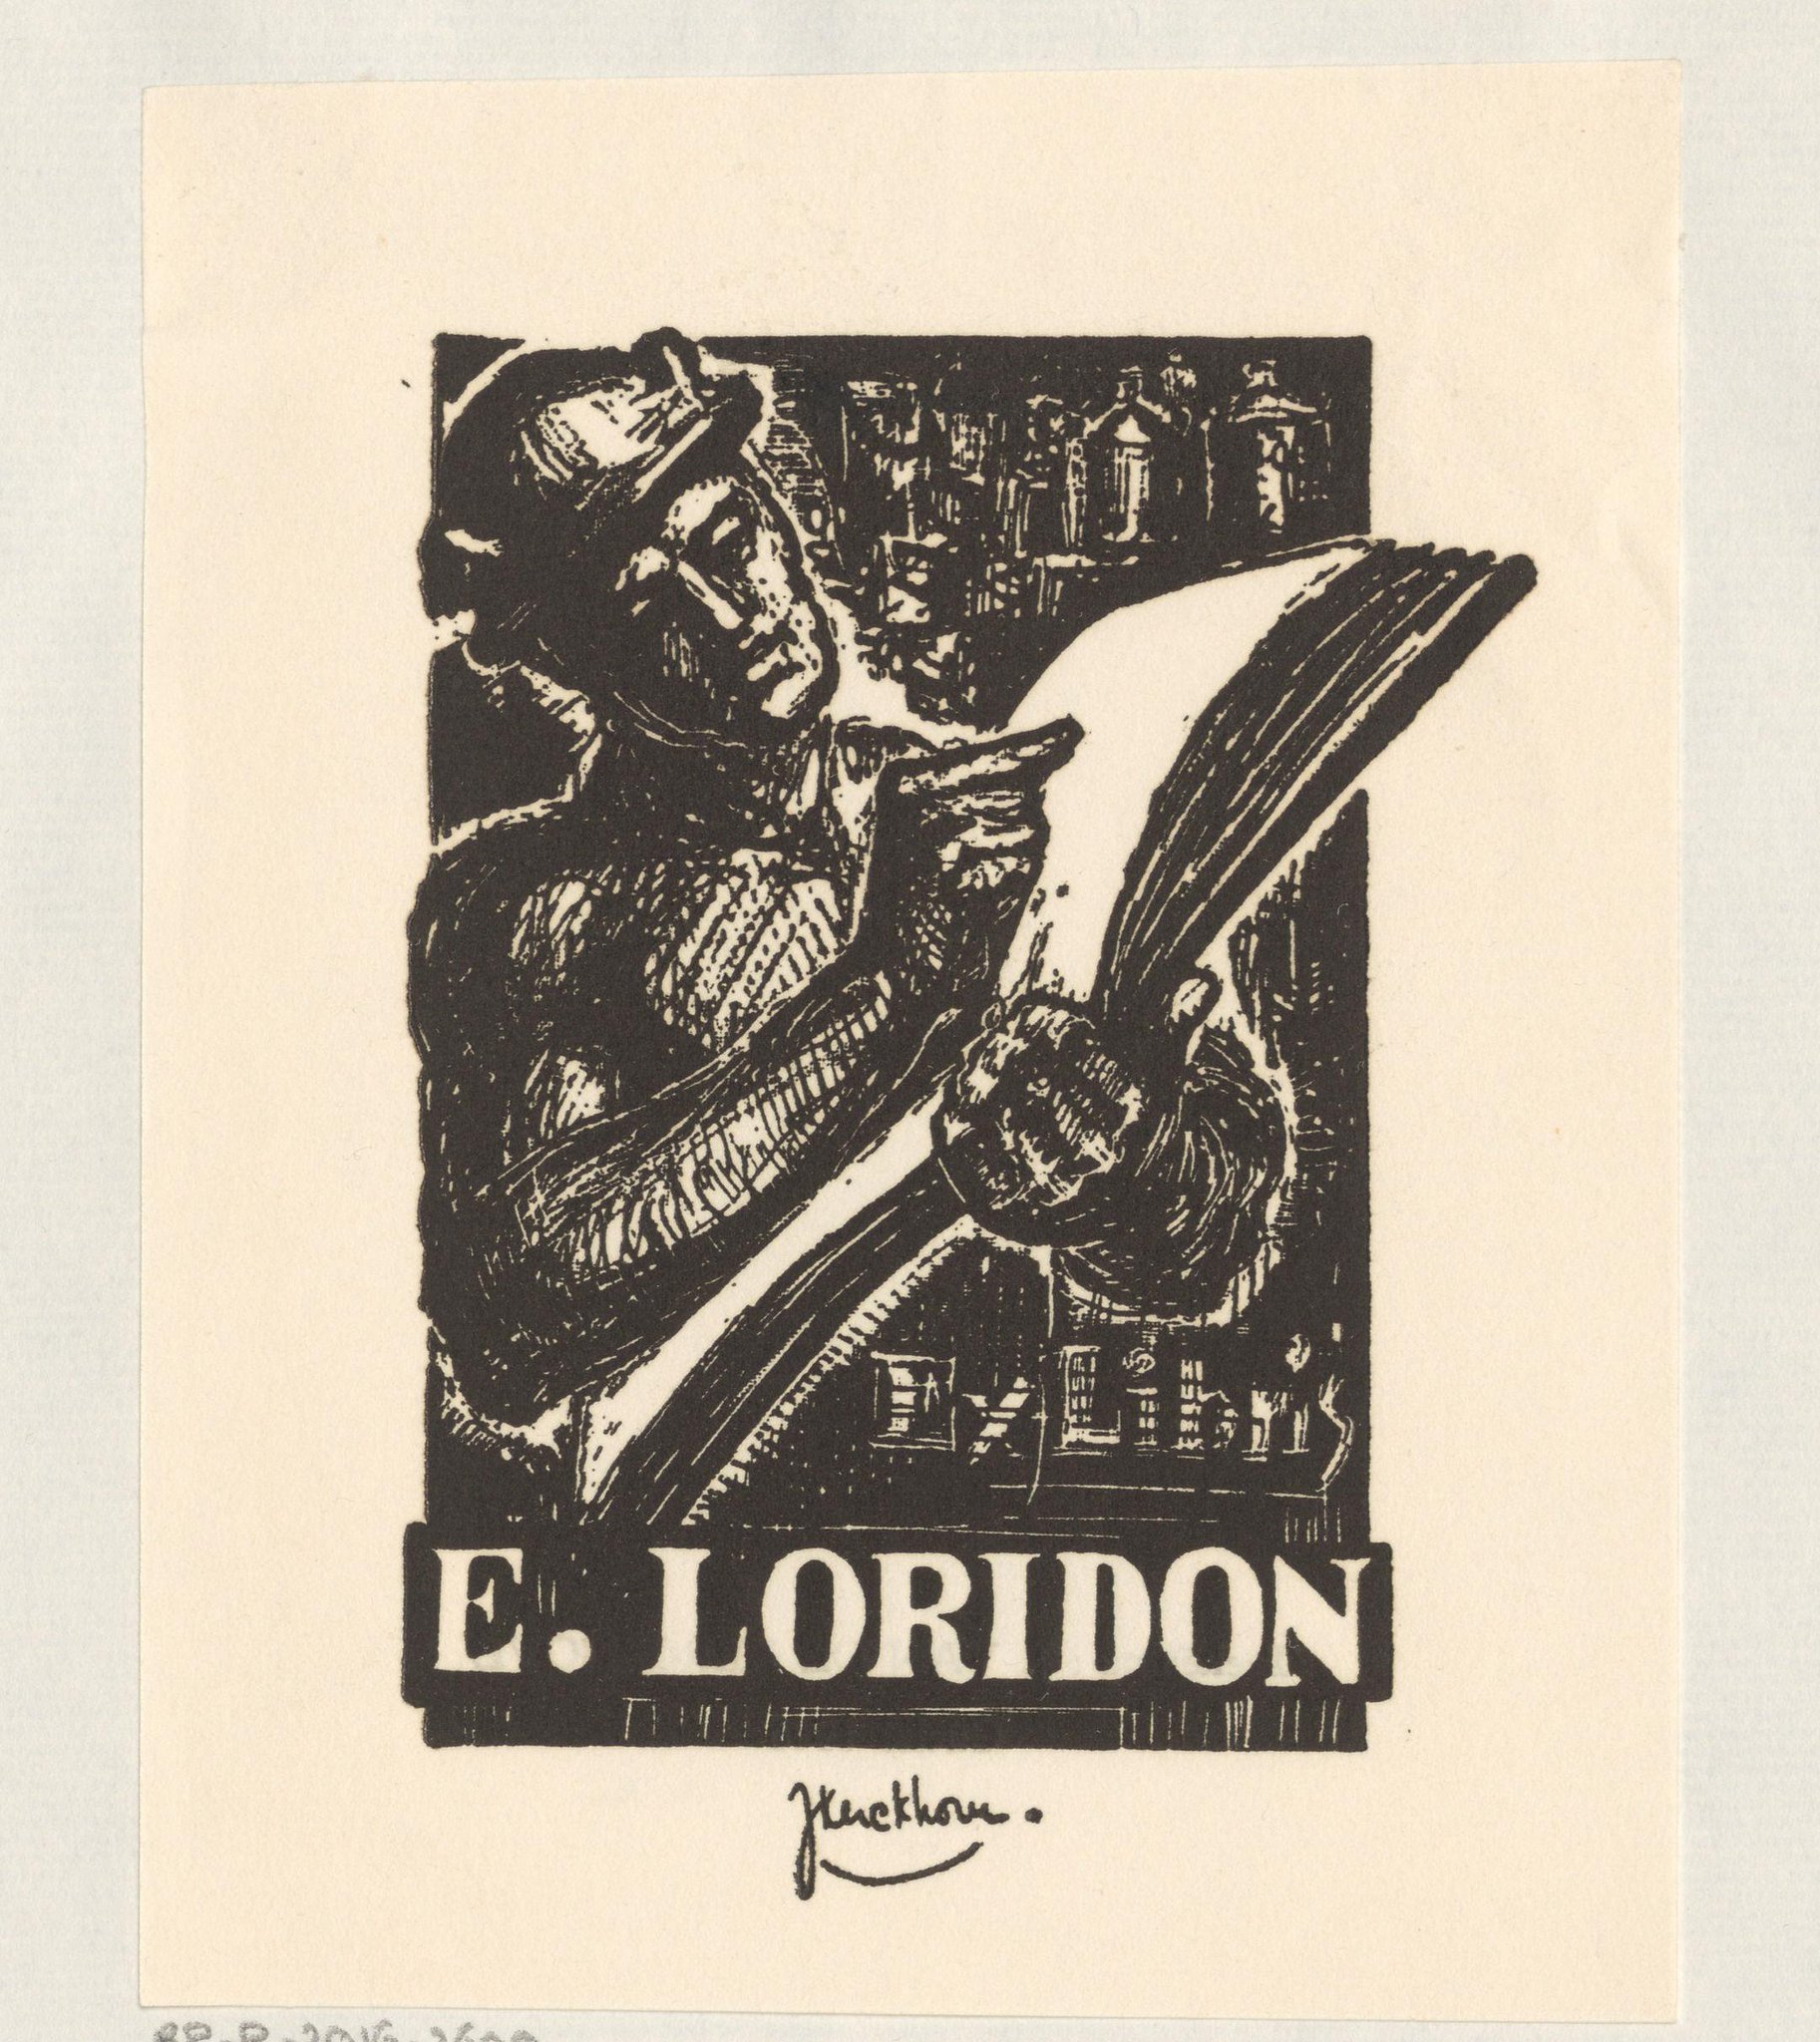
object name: bookplate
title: Ex libris van E. Loridon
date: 1946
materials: paper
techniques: printing block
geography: netherlands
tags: reading, (story of) mercury (hermes), book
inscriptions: inscription: ‘Teekening: J. van de Kerckhove / Cliché 1946’